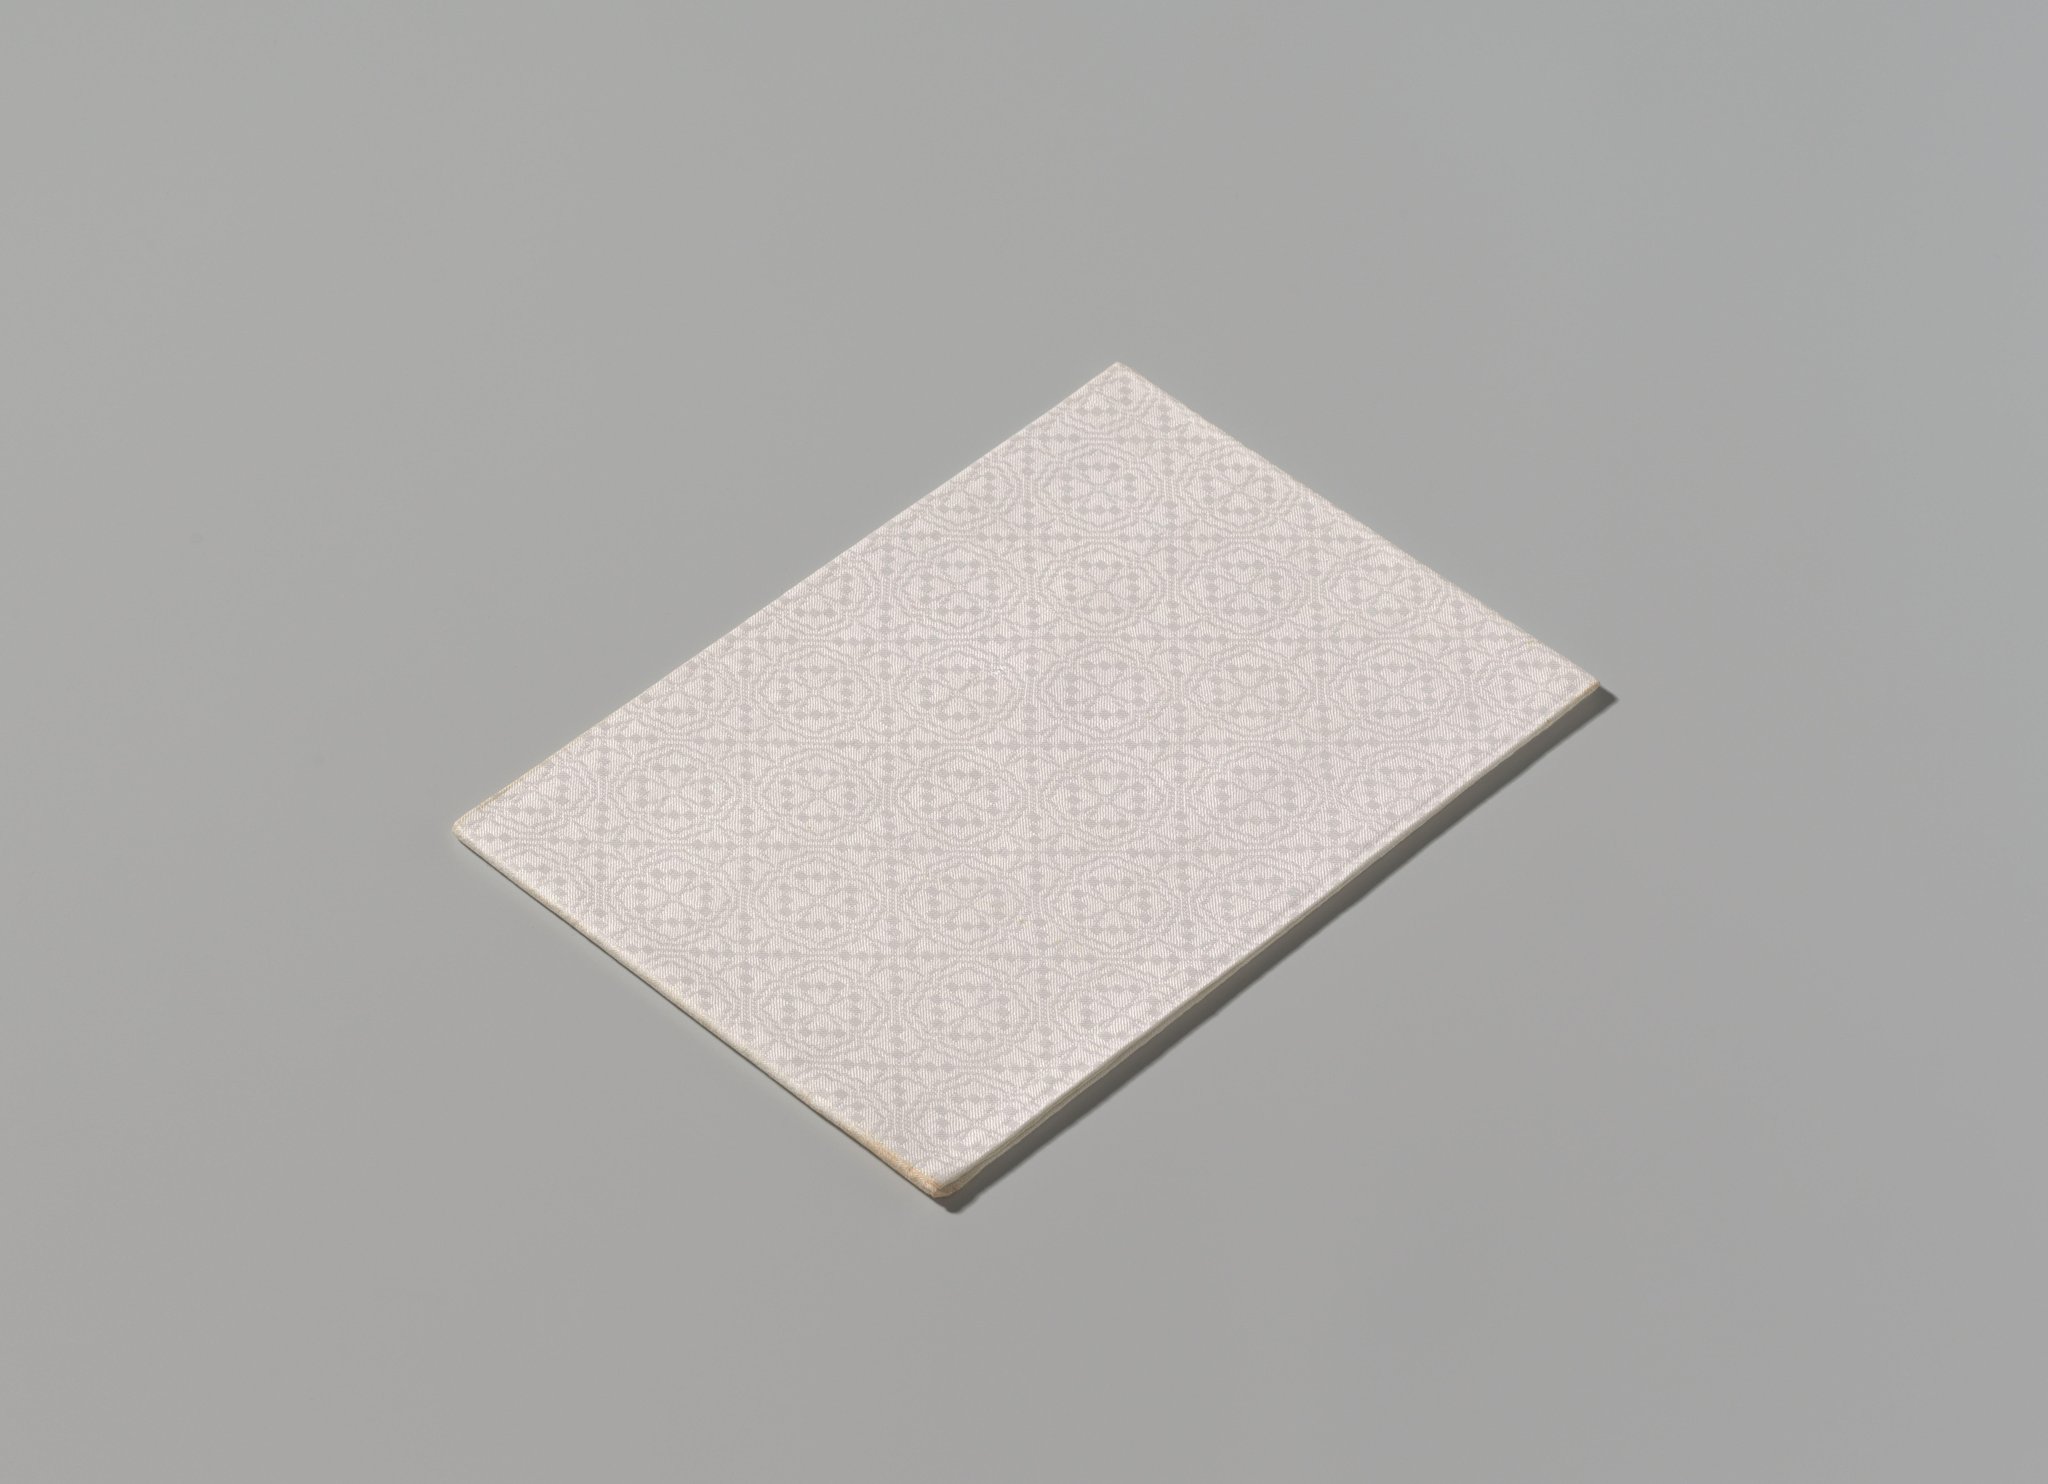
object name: napkin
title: Servet van wit linnen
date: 1640-1670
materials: linen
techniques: peeled fabric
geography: northern netherlands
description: Wit linnen servet. Pellen keper. Merk TC en 22.